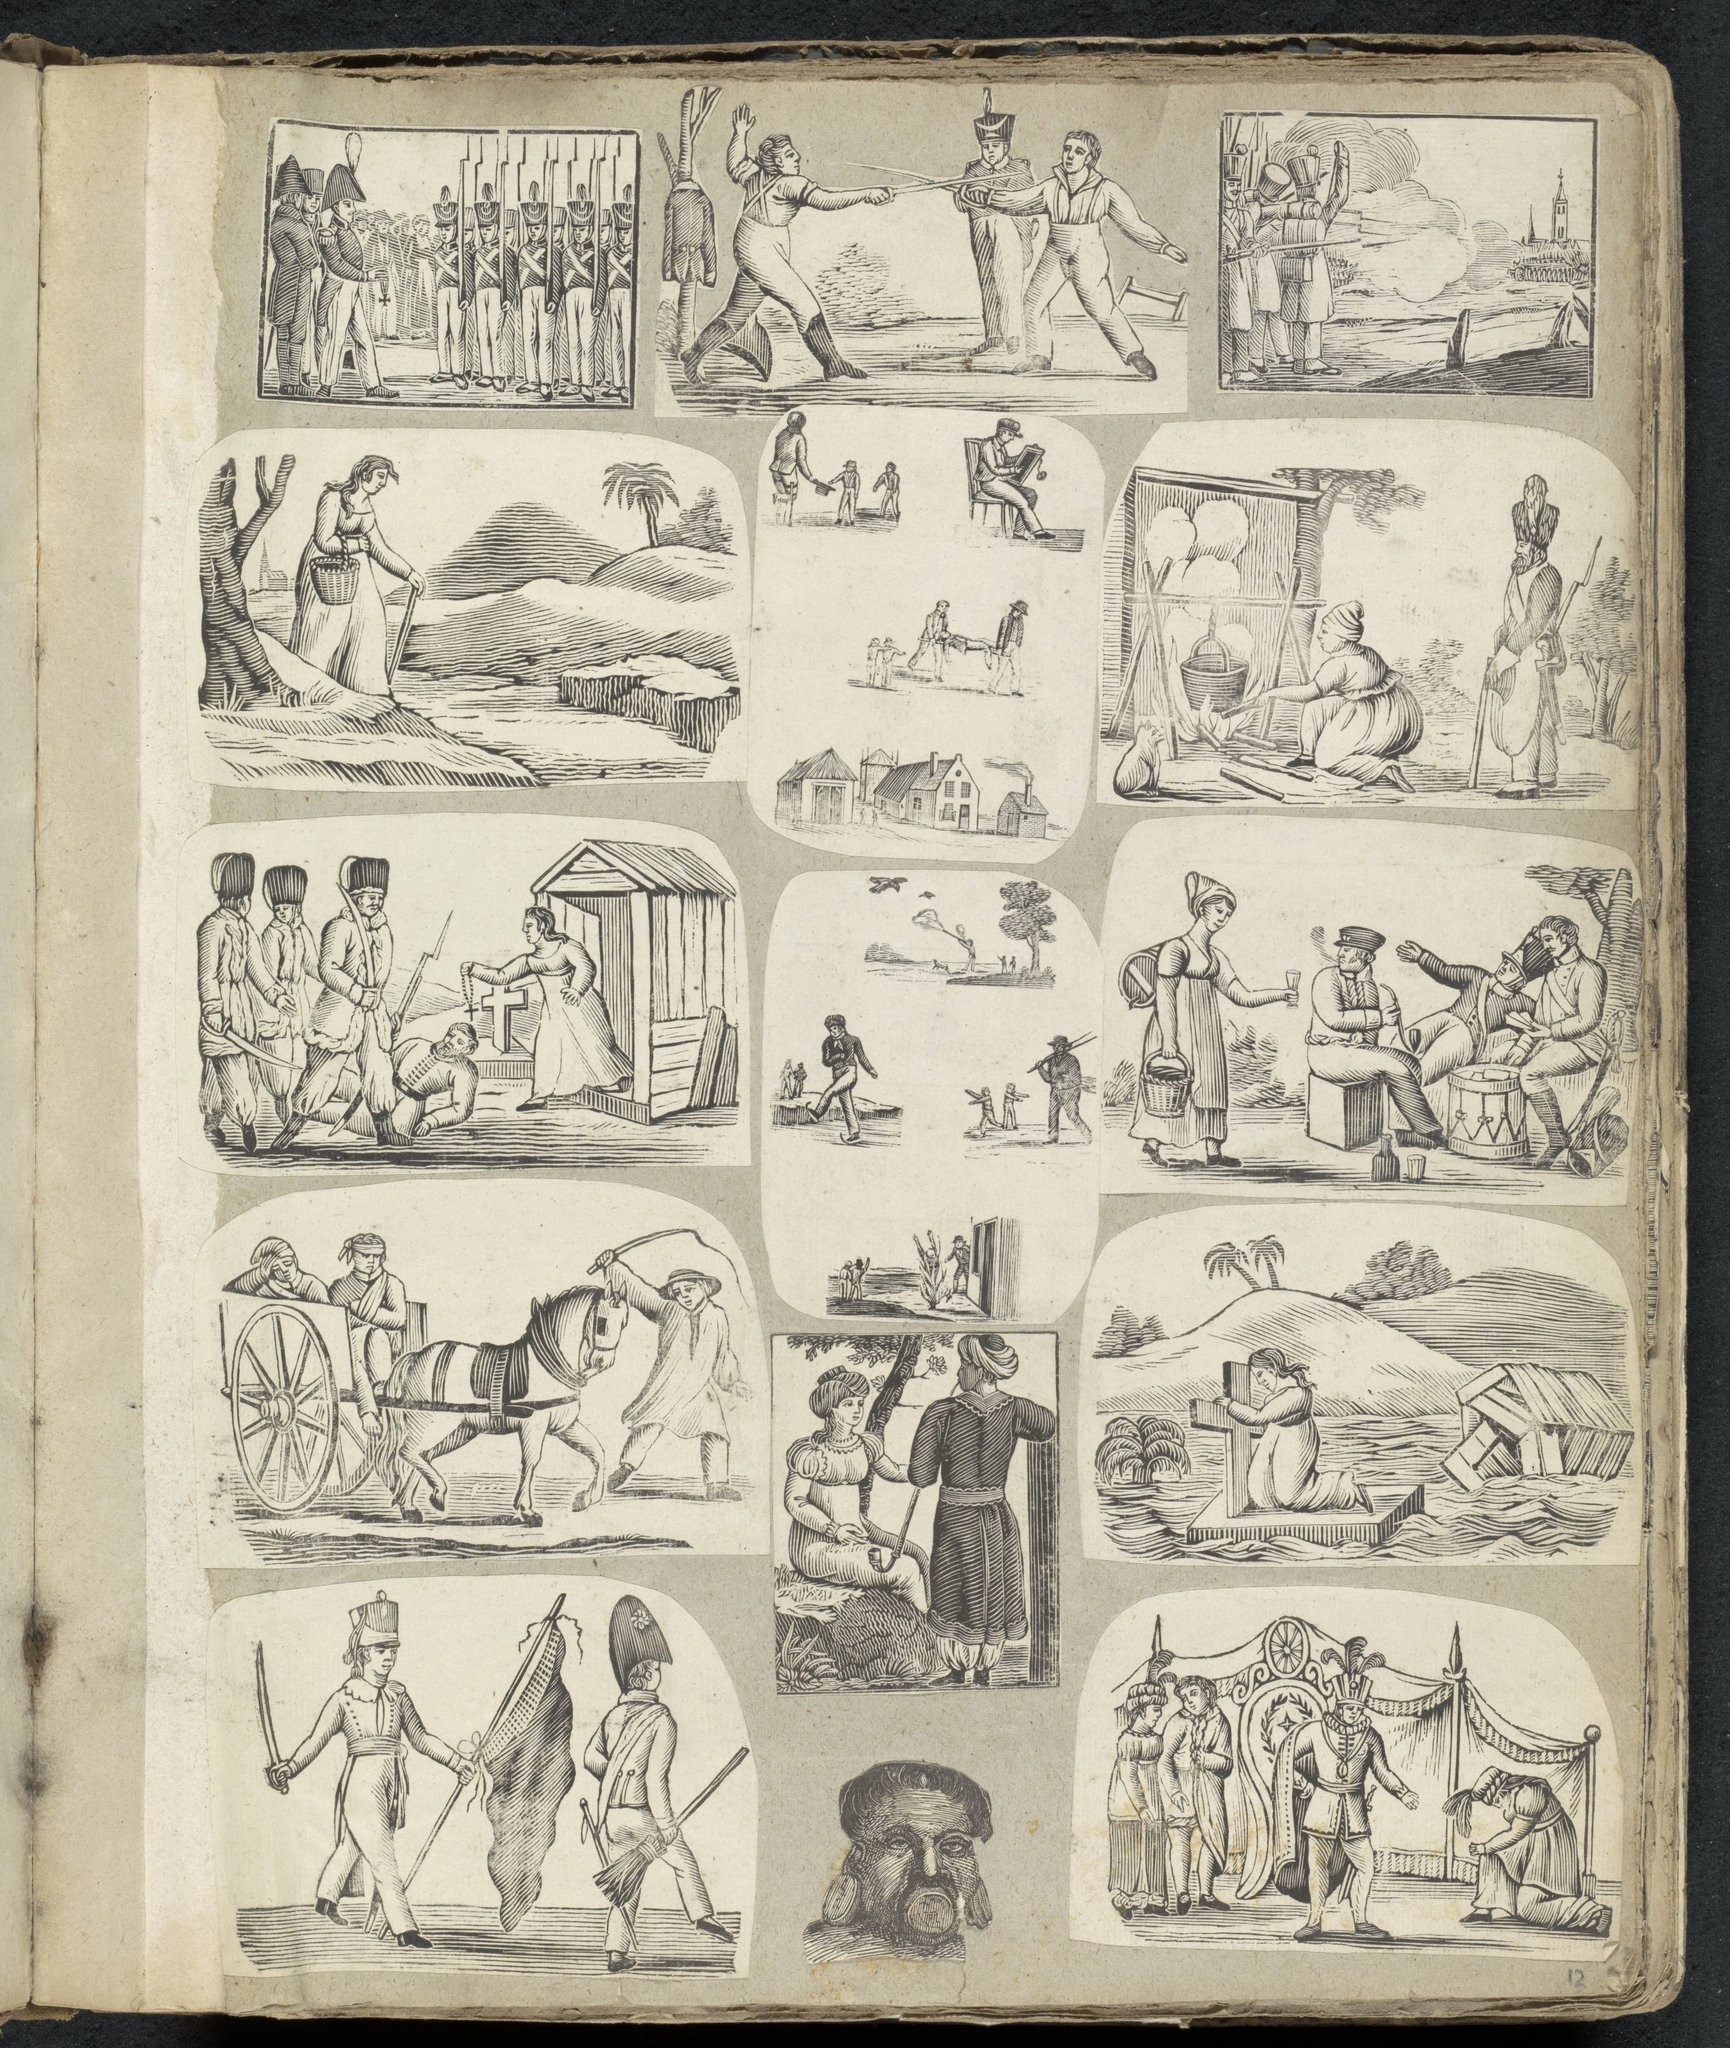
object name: popular print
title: Albumblad met diverse voorstellingen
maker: alexander cranendoncq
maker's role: draughtsman, print maker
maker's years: 1799-1869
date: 1814-1869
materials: paper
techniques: snipping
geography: nijmegen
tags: africans, pipe ~ tobacco, the soldier; the soldier's life, fencing (sport)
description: Albumblad met 15 uitgeknipte voorstellingen uit voornamelijk volksprenten, onder andere van militairen, een man met tulband die een pijp rookt en een Afrikaanse man met grote sieraden.